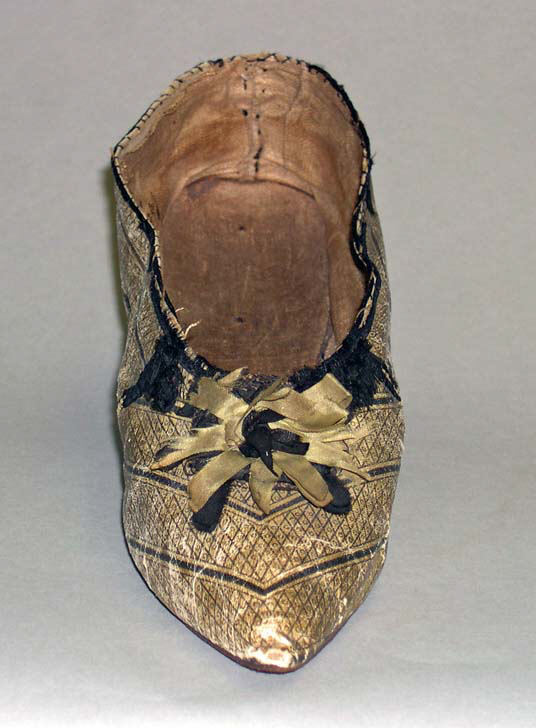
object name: slipper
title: Slippers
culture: french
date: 1785-1790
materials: leather